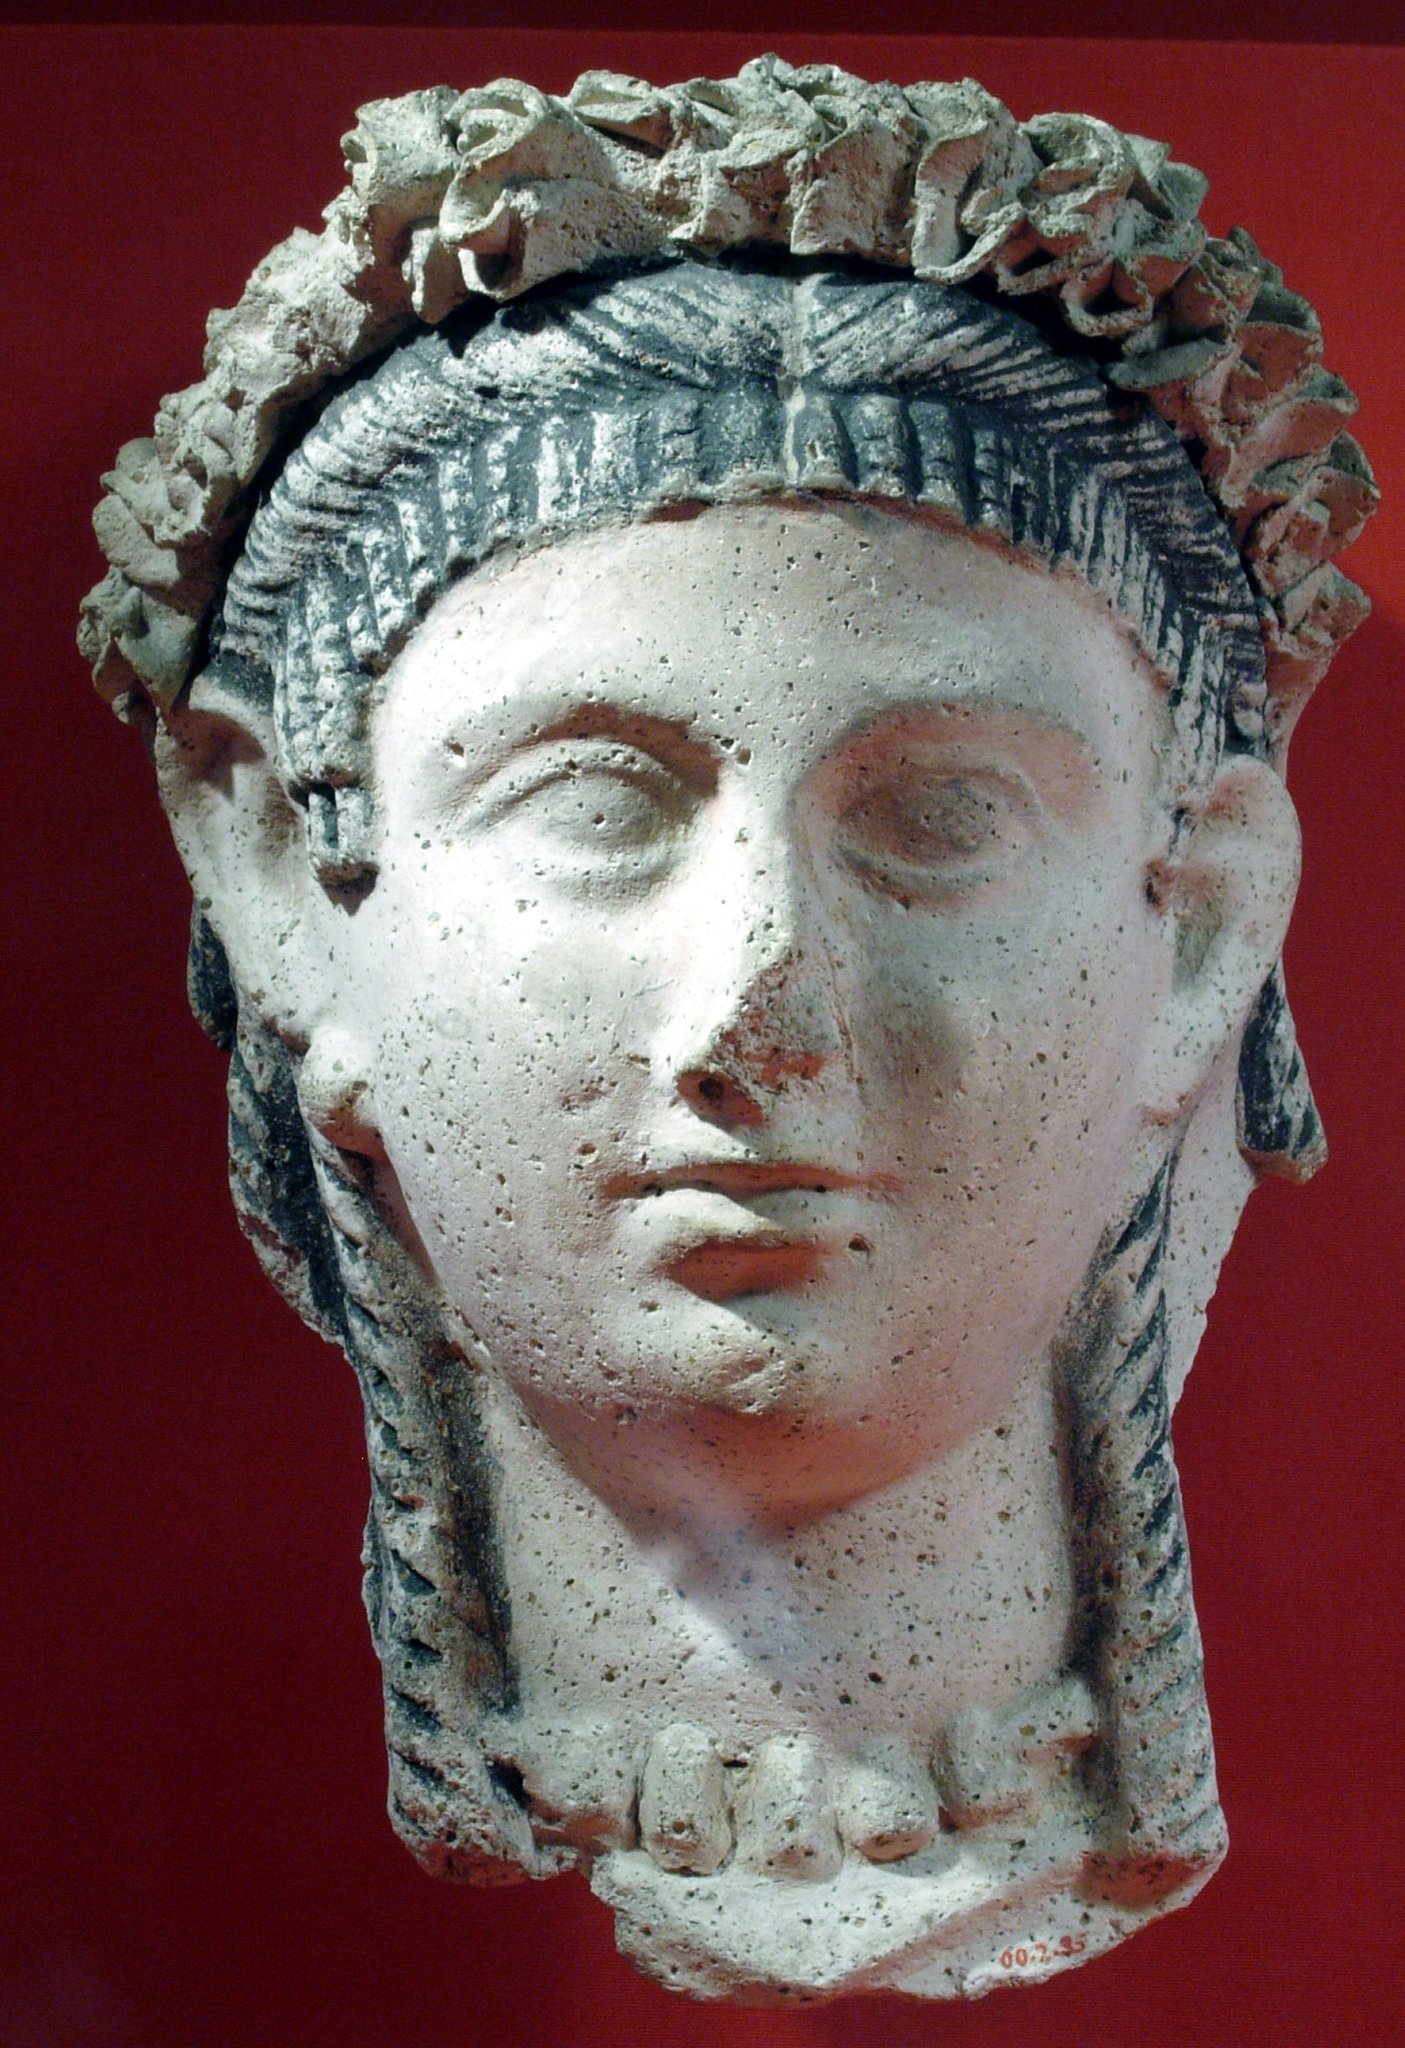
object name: mask, woman, corkscrew lock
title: Mask of a woman with ball earrings, corkscrew locks and bang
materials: paint, plaster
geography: egypt